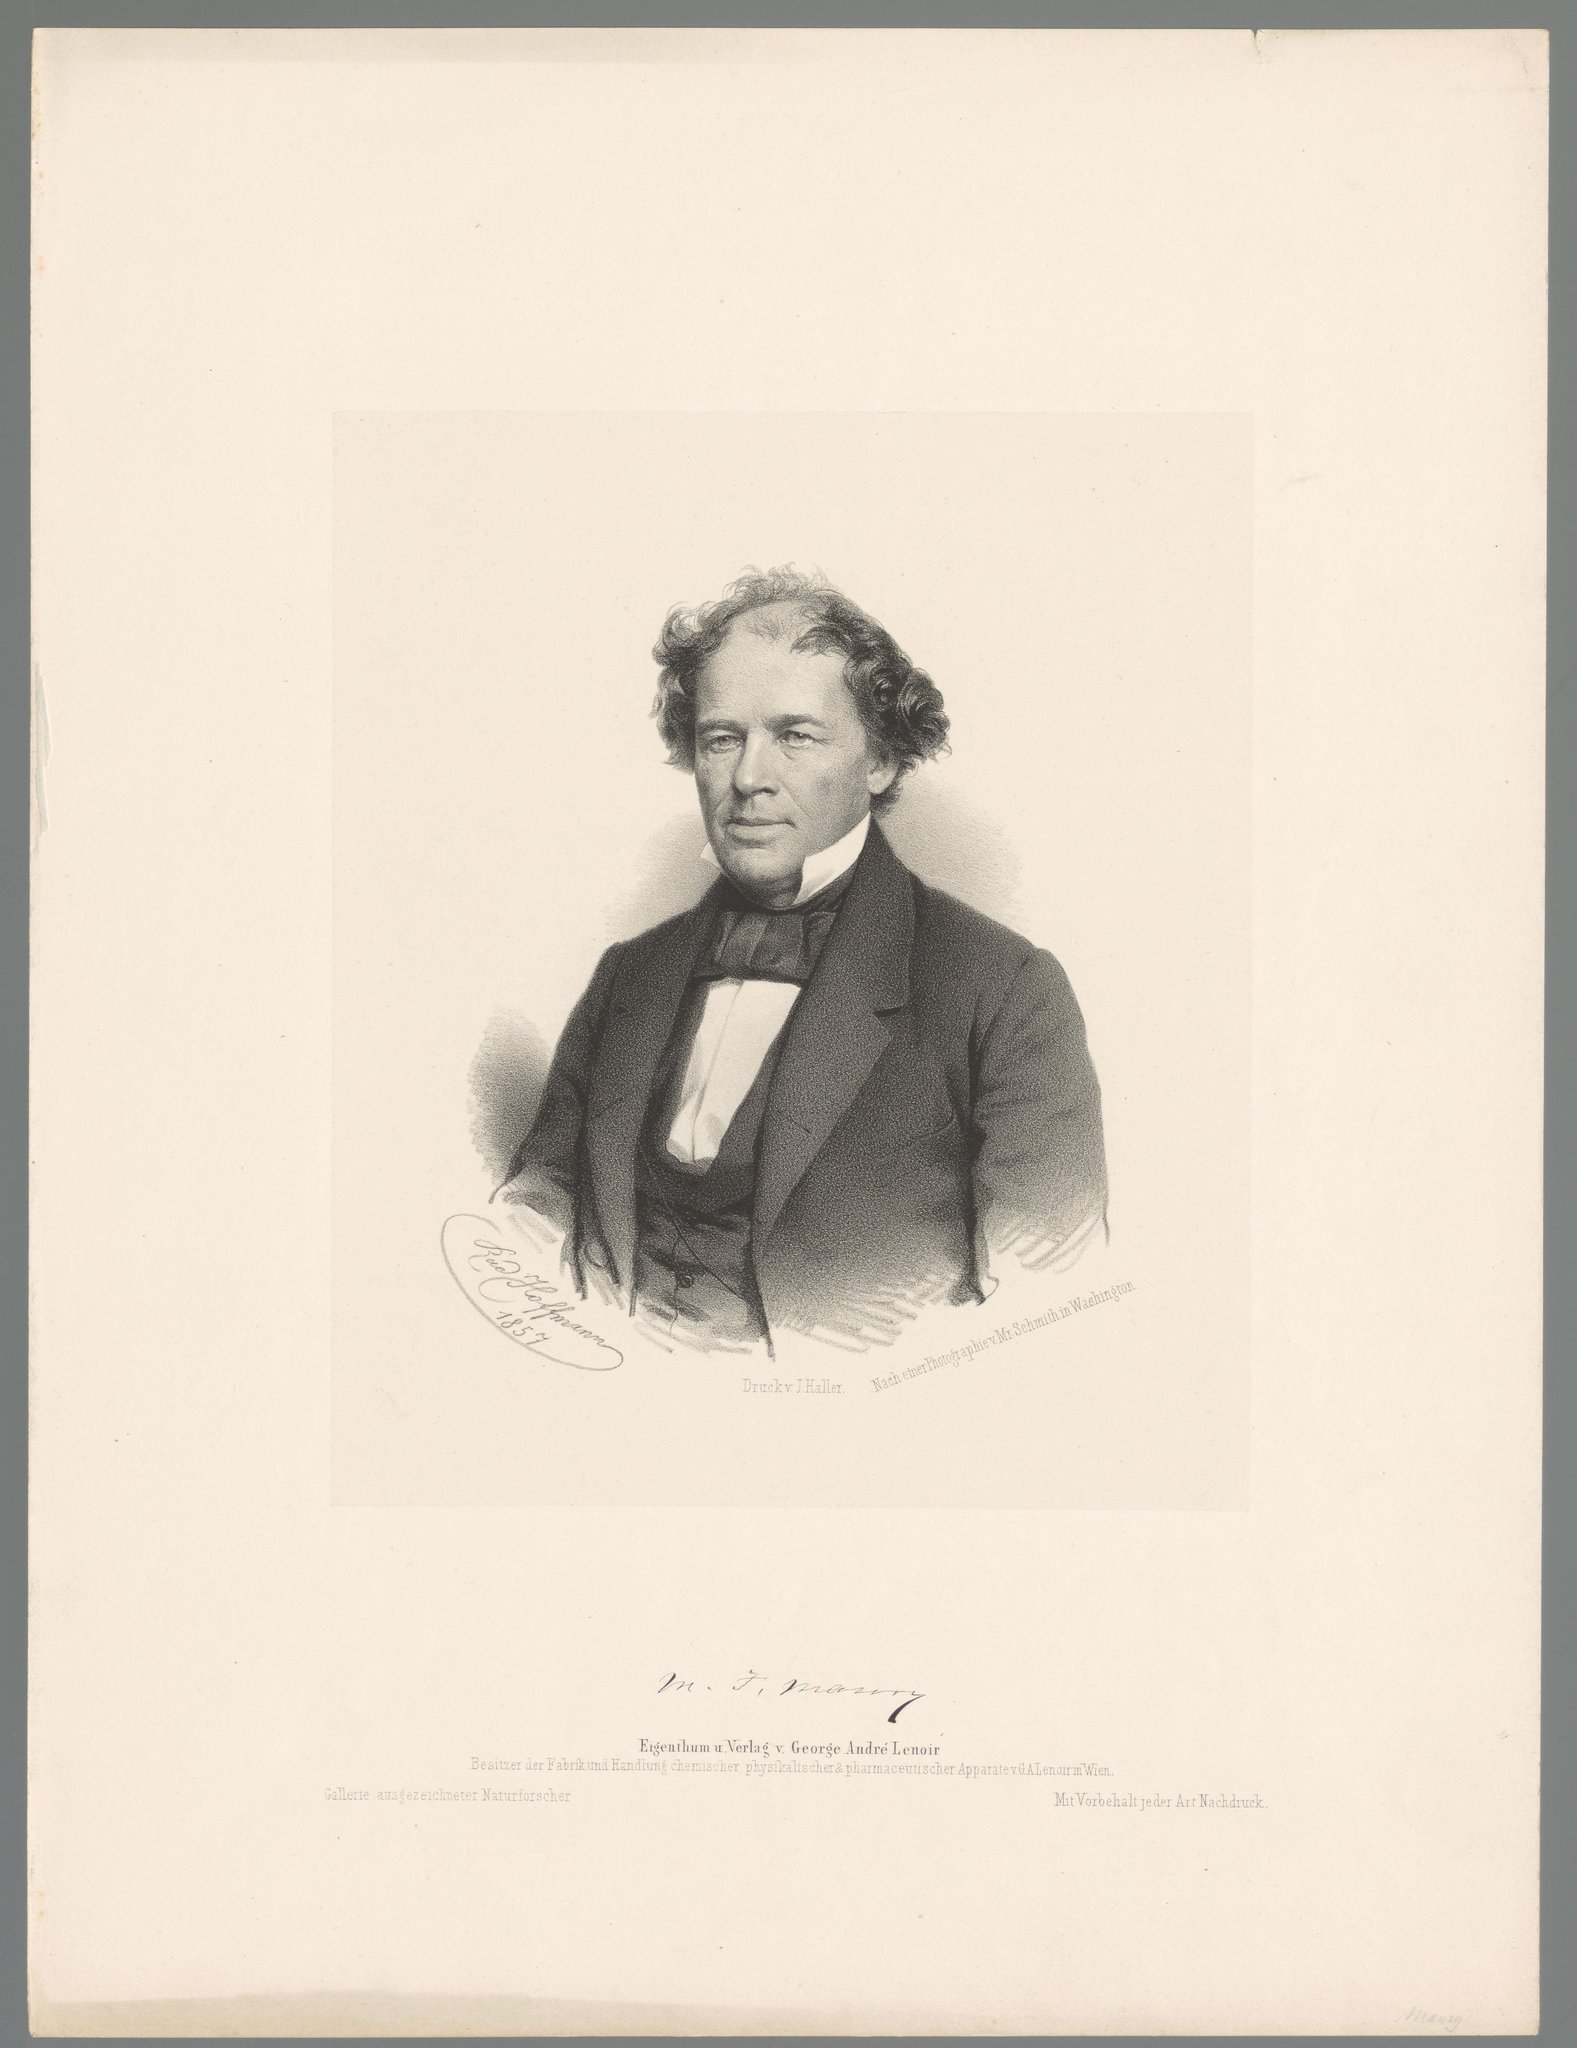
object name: print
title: Portret van Matthew Fontaine Maury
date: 1857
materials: paper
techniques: lithograph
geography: vienna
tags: matthew fontaine maury, adult man, historical persons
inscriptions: collector's mark: Lugt 2228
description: Deze prent behoort tot een serie met 100 portretten van natuurwetenschappers, uitgegeven tussen 1856-1860.